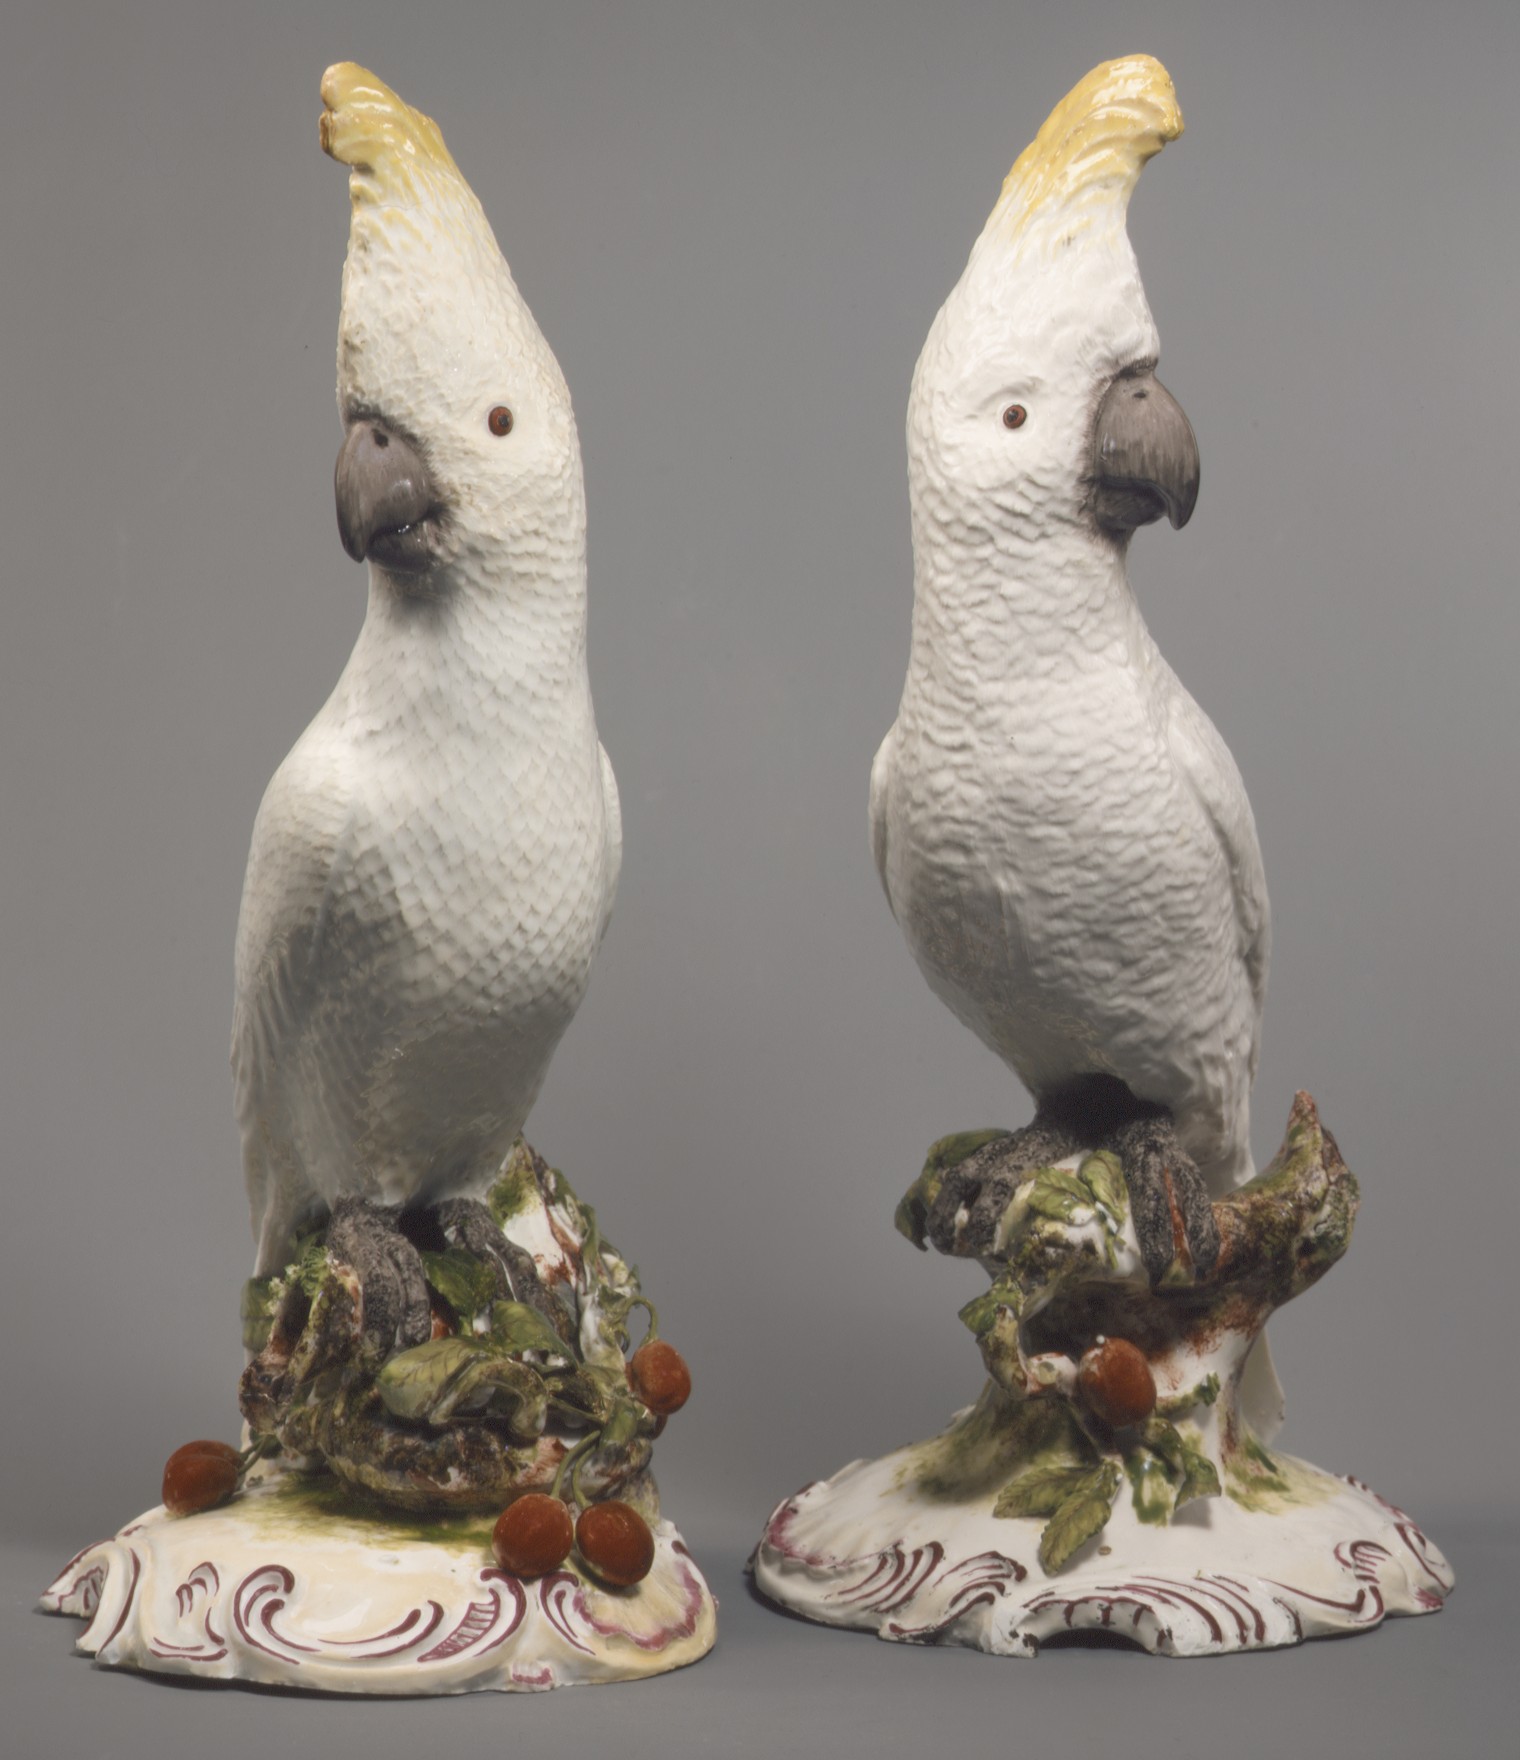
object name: figure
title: Cockatoo (one of a pair)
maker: ludwigsburg porcelain manufactory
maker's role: manufactory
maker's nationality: german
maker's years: 1758-1824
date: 1765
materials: hard paste porcelain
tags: birds